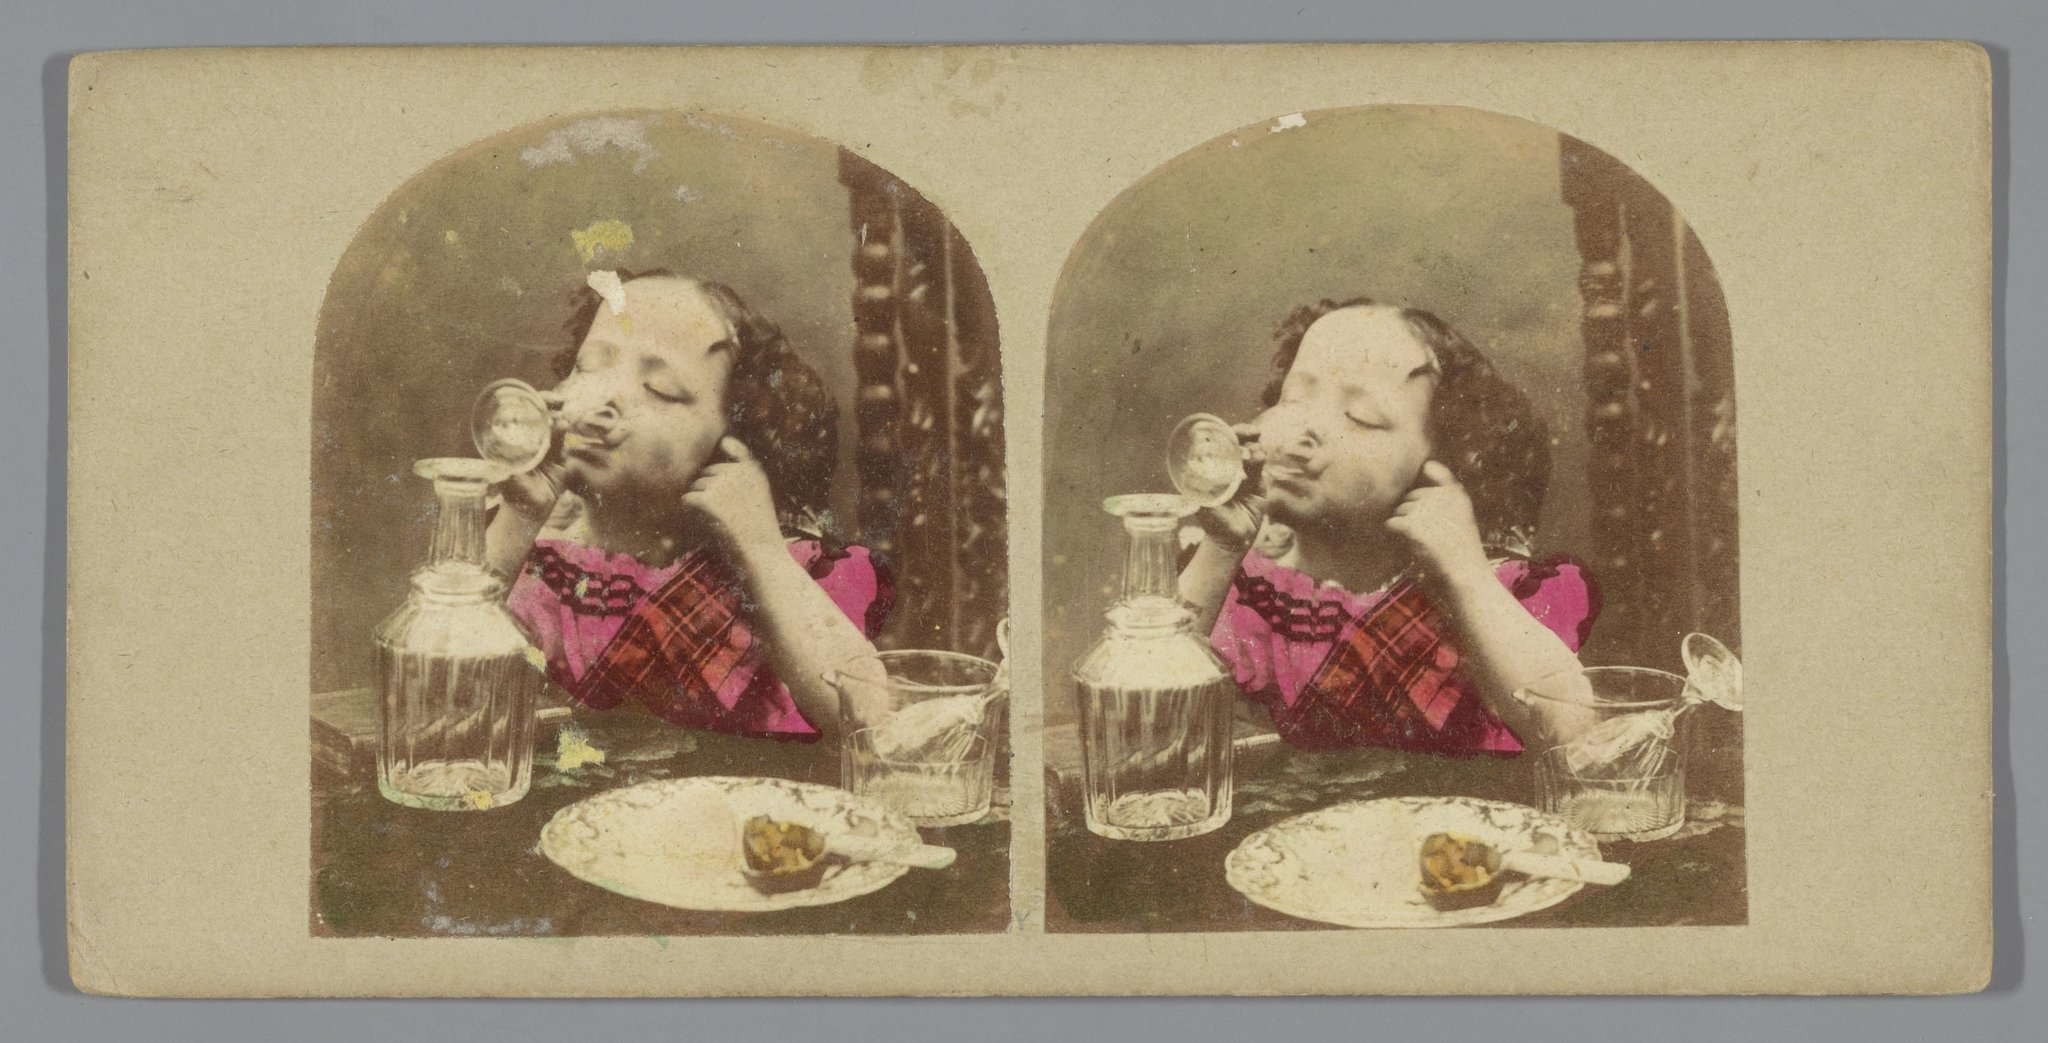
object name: stereograph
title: Kind aan tafel drinkt uit een glas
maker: Anonymous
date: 1852-1863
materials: cardboard, paper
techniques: albumen print, hand coloring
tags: child, drinking